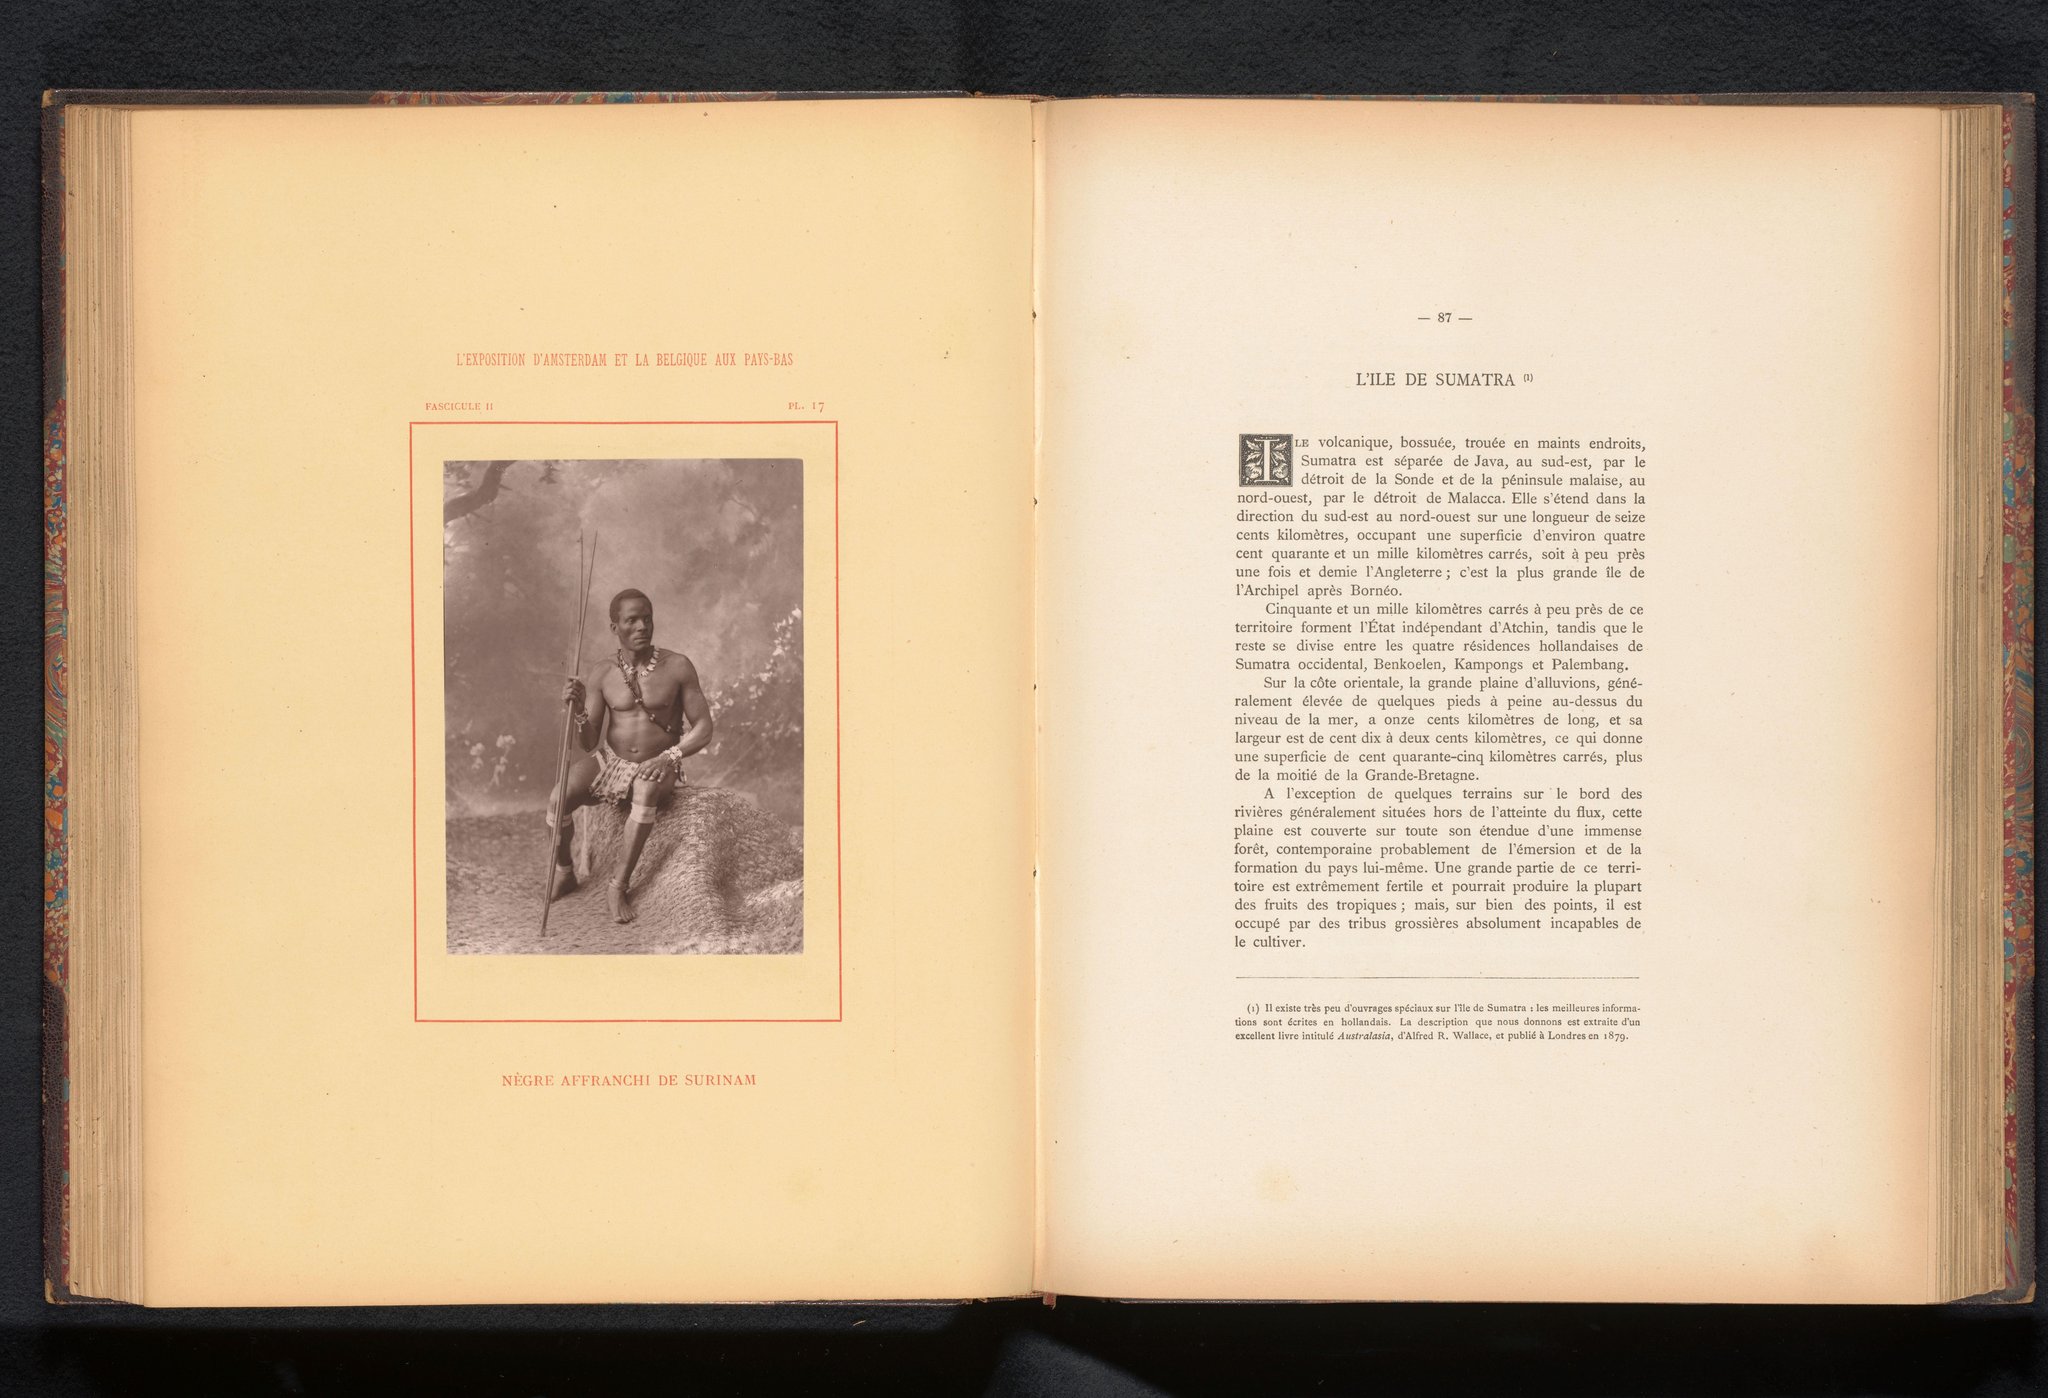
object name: photomechanical print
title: Nègre affranchi de Surinam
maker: Anonymous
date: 1878-1883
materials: paper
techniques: woodburytype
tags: archer's weapons: bow and arrow, world fair, world exhibition, adult man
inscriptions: inscription: ‘Fascicule II/ PL. 17’